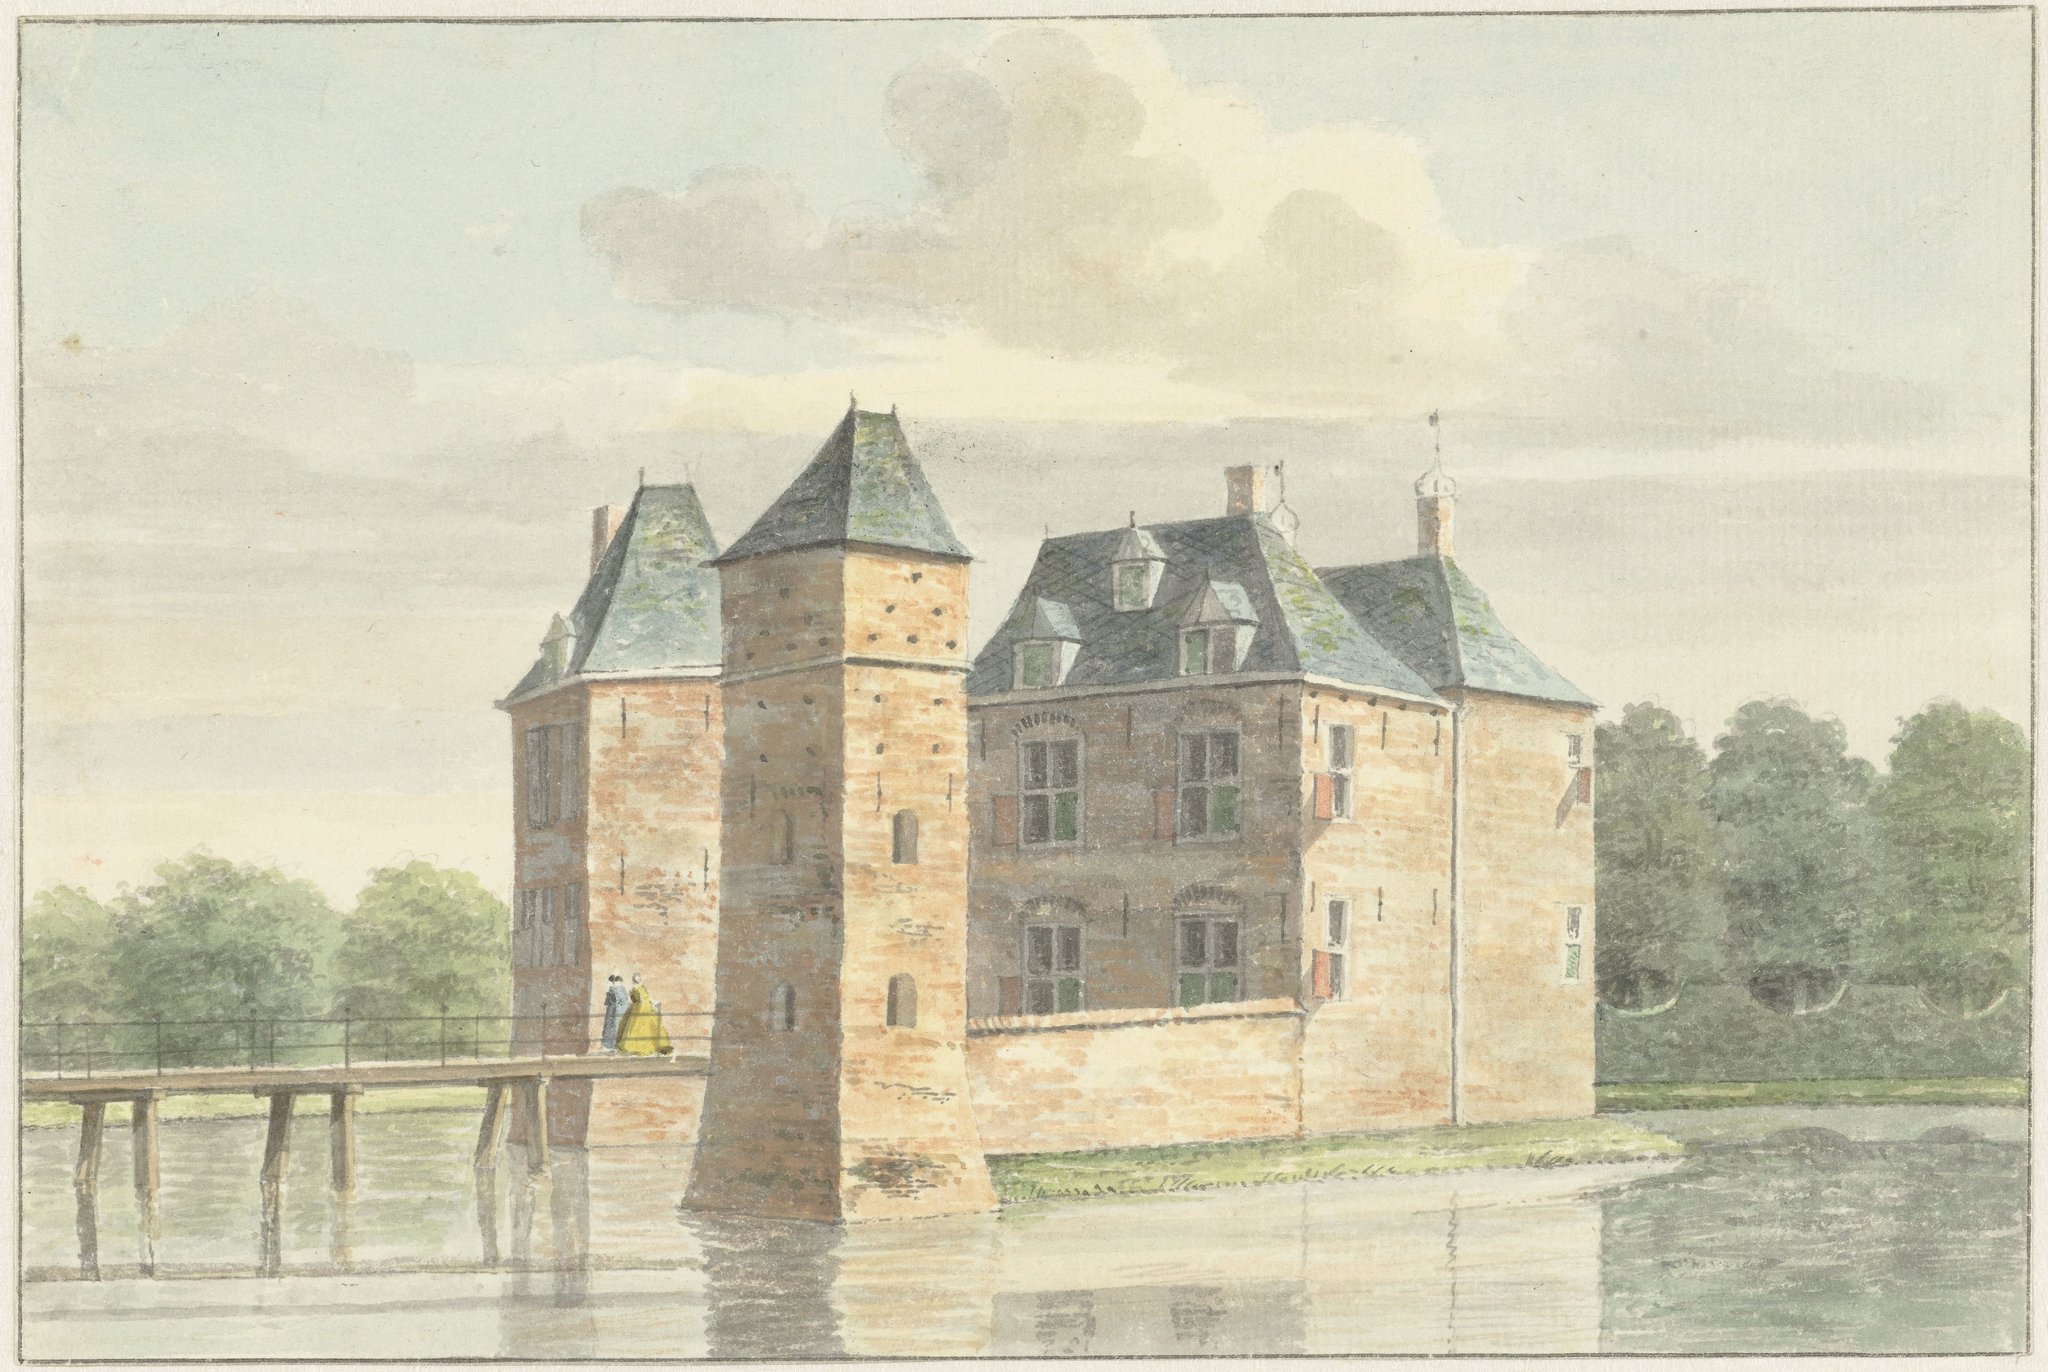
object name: drawing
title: Kasteel Moersbergen bij Doorn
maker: hendrik de winter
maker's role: draughtsman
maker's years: 1717-1790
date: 1744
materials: ink, paper, watercolor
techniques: brush, pen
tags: castle, kasteel moersbergen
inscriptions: inscription: ‘H De Winter del ad viv: 1744 Het huijs Moersbergen bij t dorp doorn’